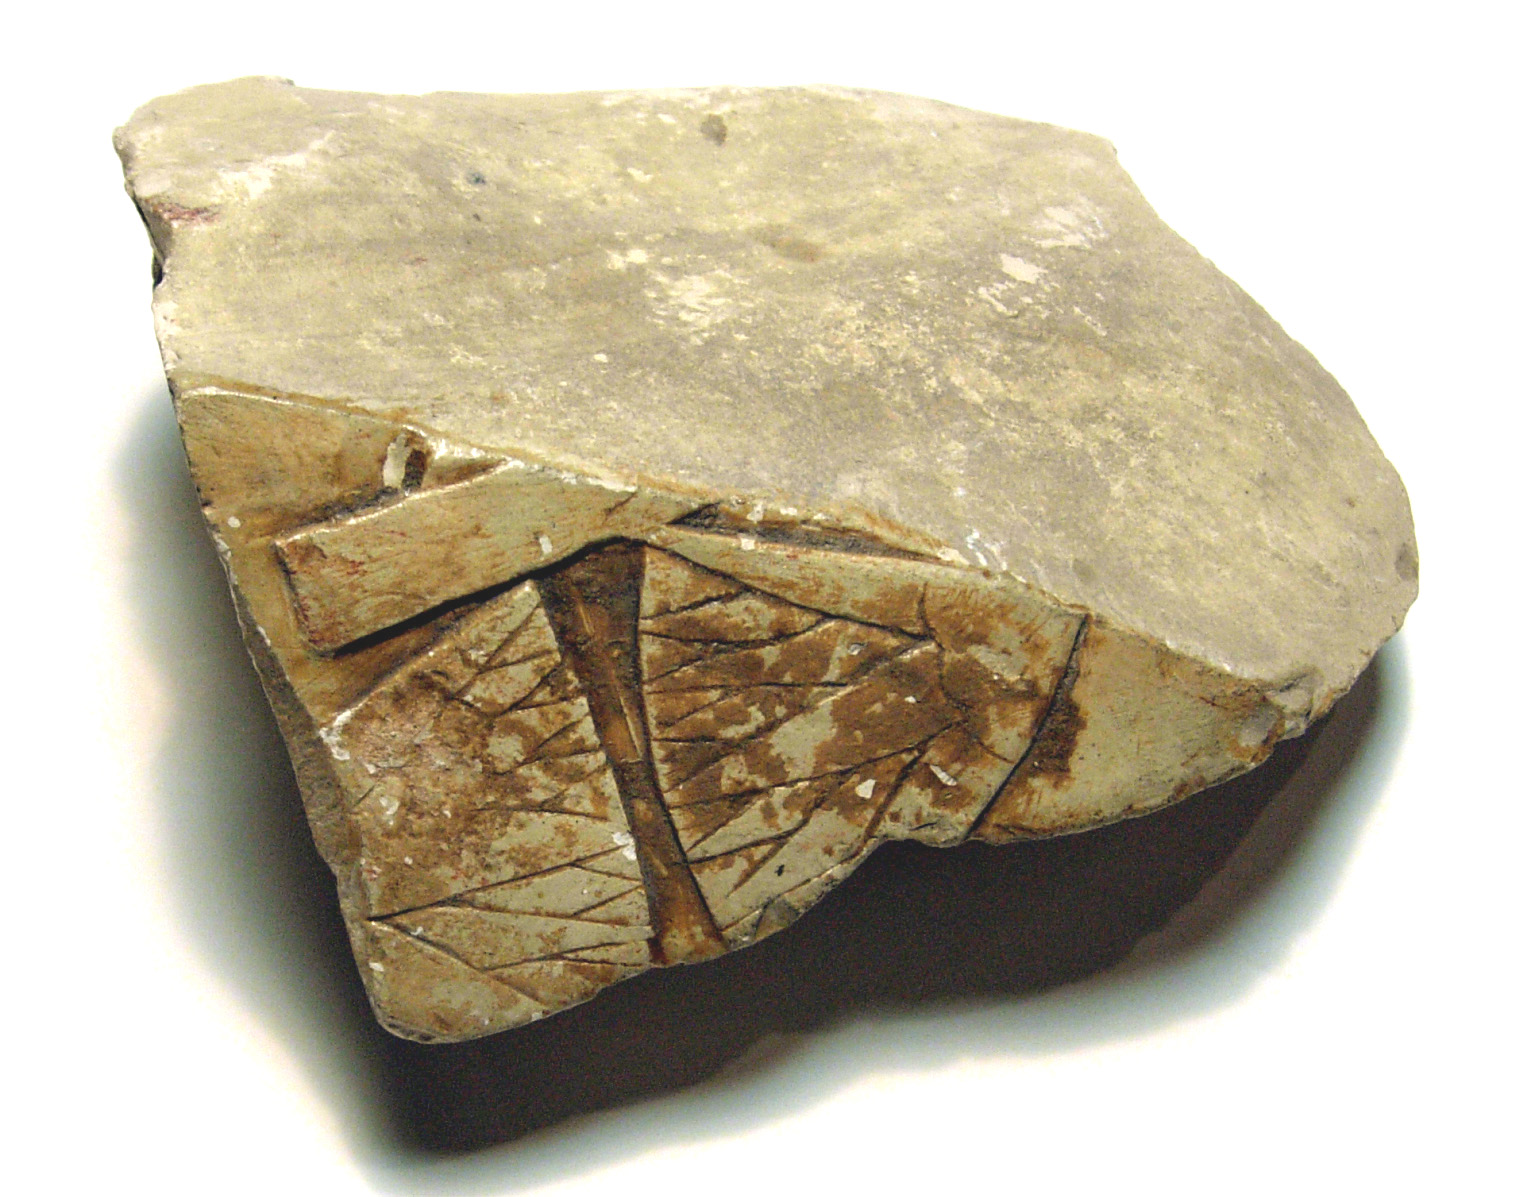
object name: relief, tomb of nespekashuty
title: Raised relief fragment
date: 664-610 BCE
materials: limestone, mortar, varnish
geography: egypt